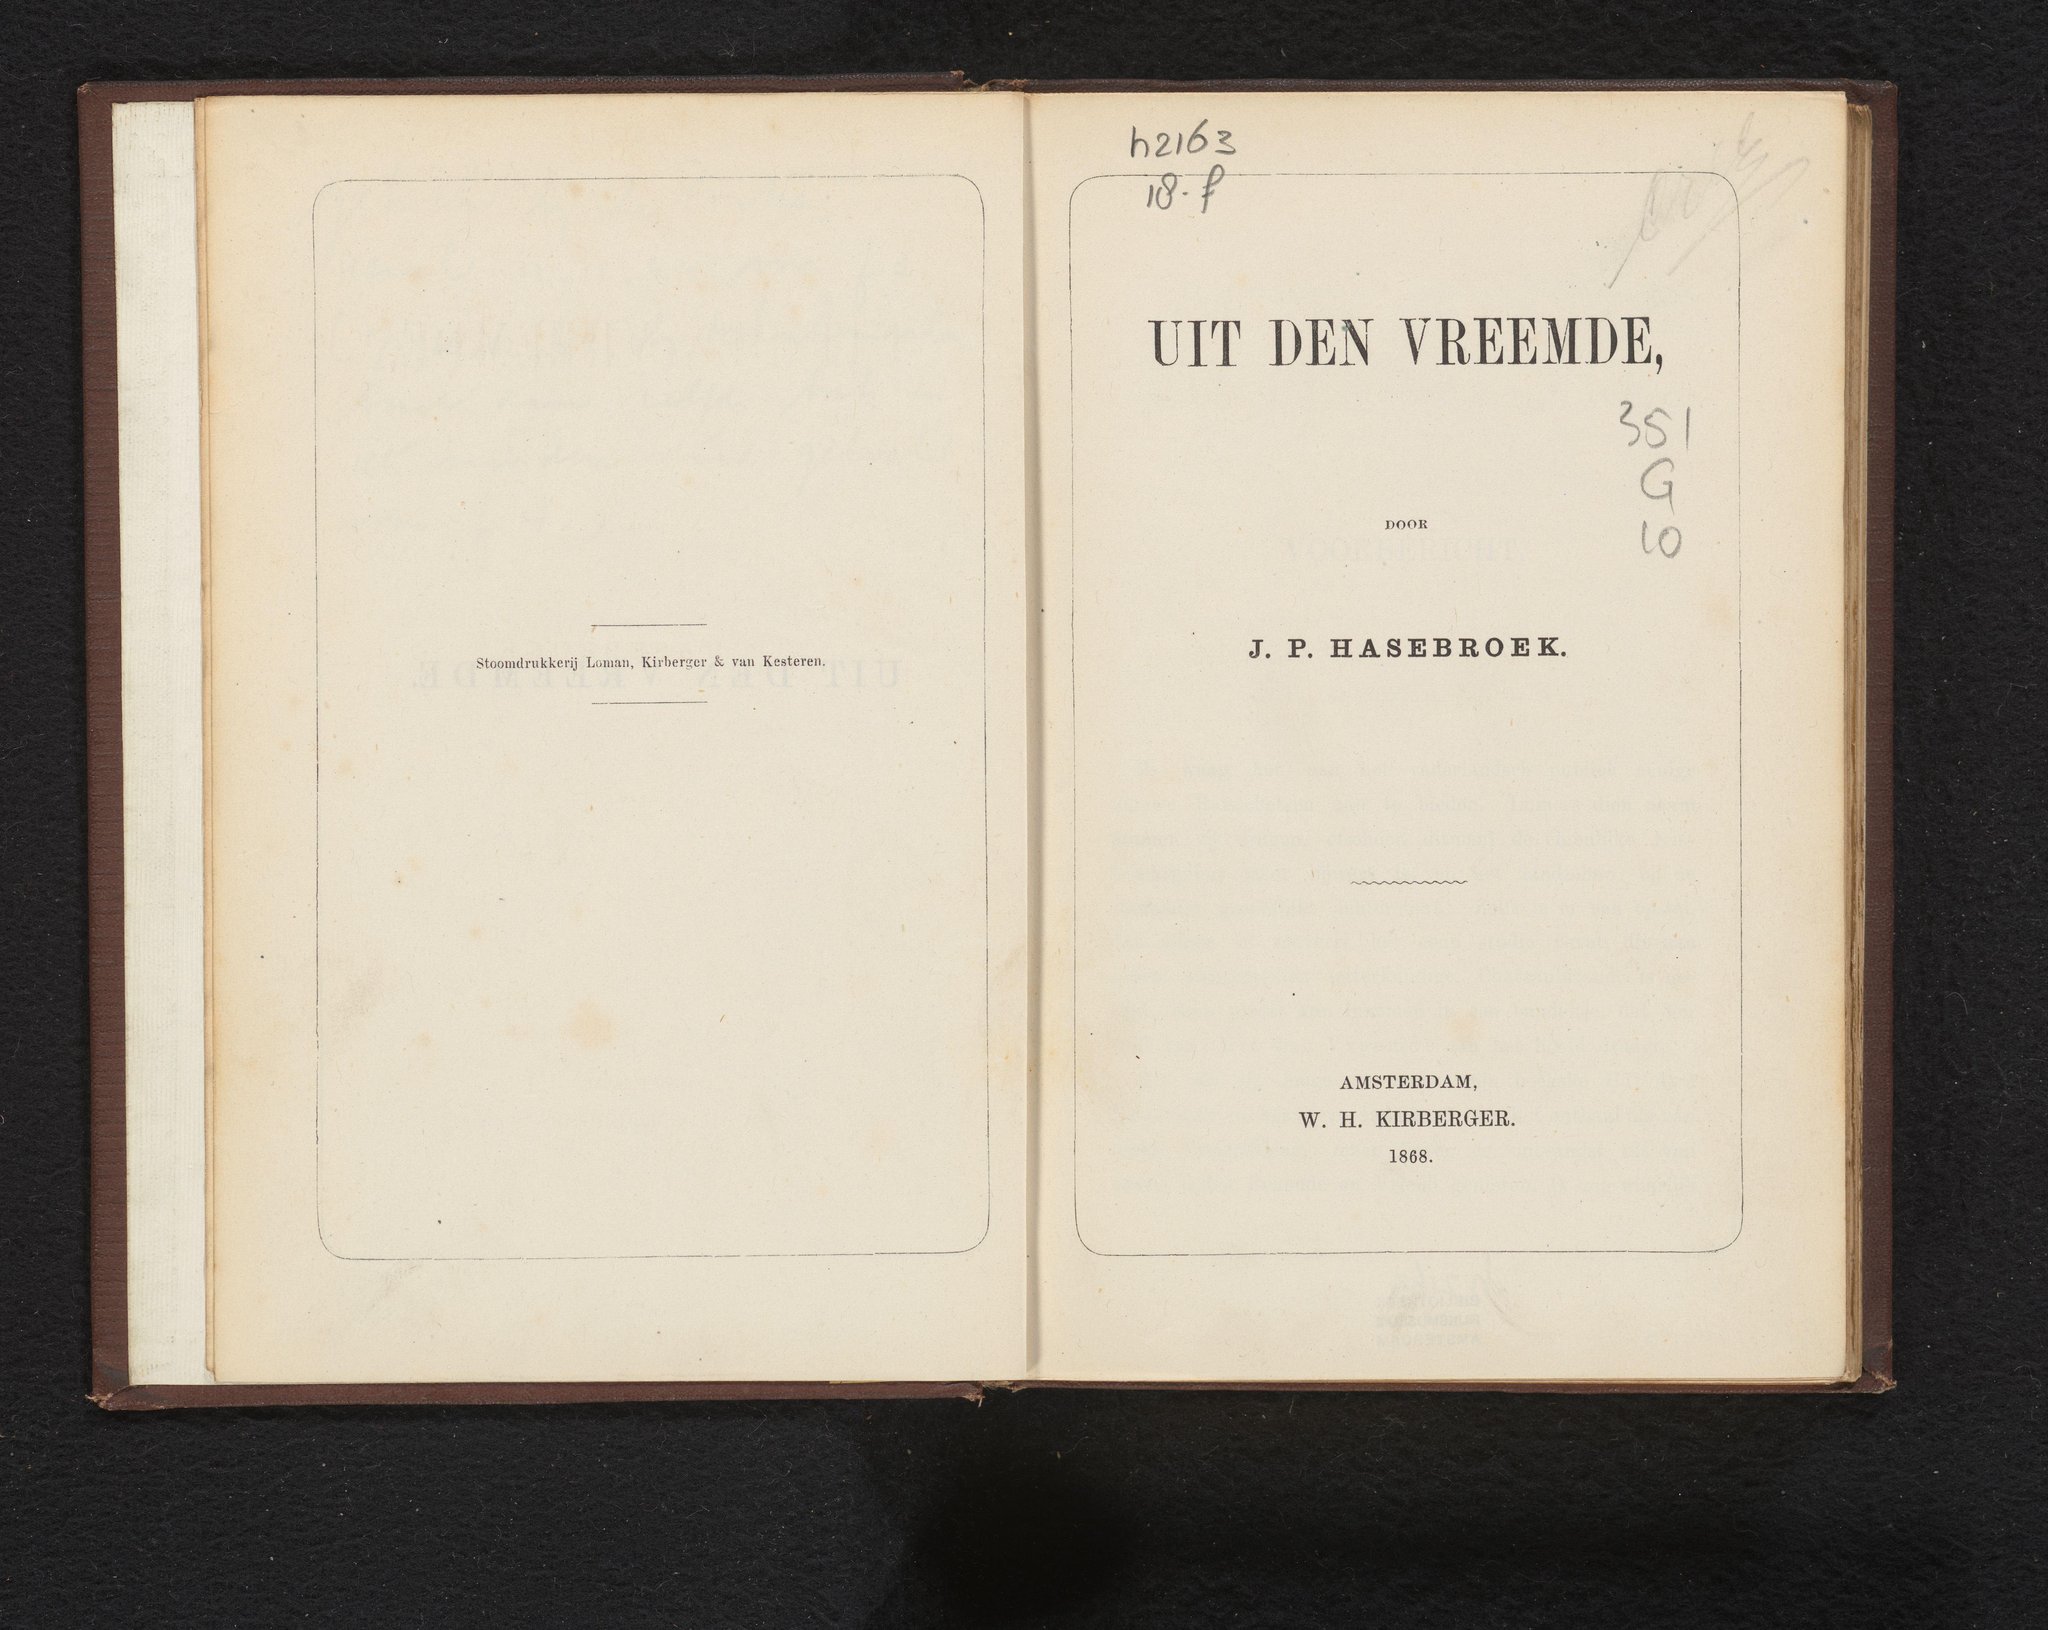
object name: book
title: Uit den vreemde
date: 1868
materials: cardboard, linen, paper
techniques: albumen print, printing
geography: amsterdam